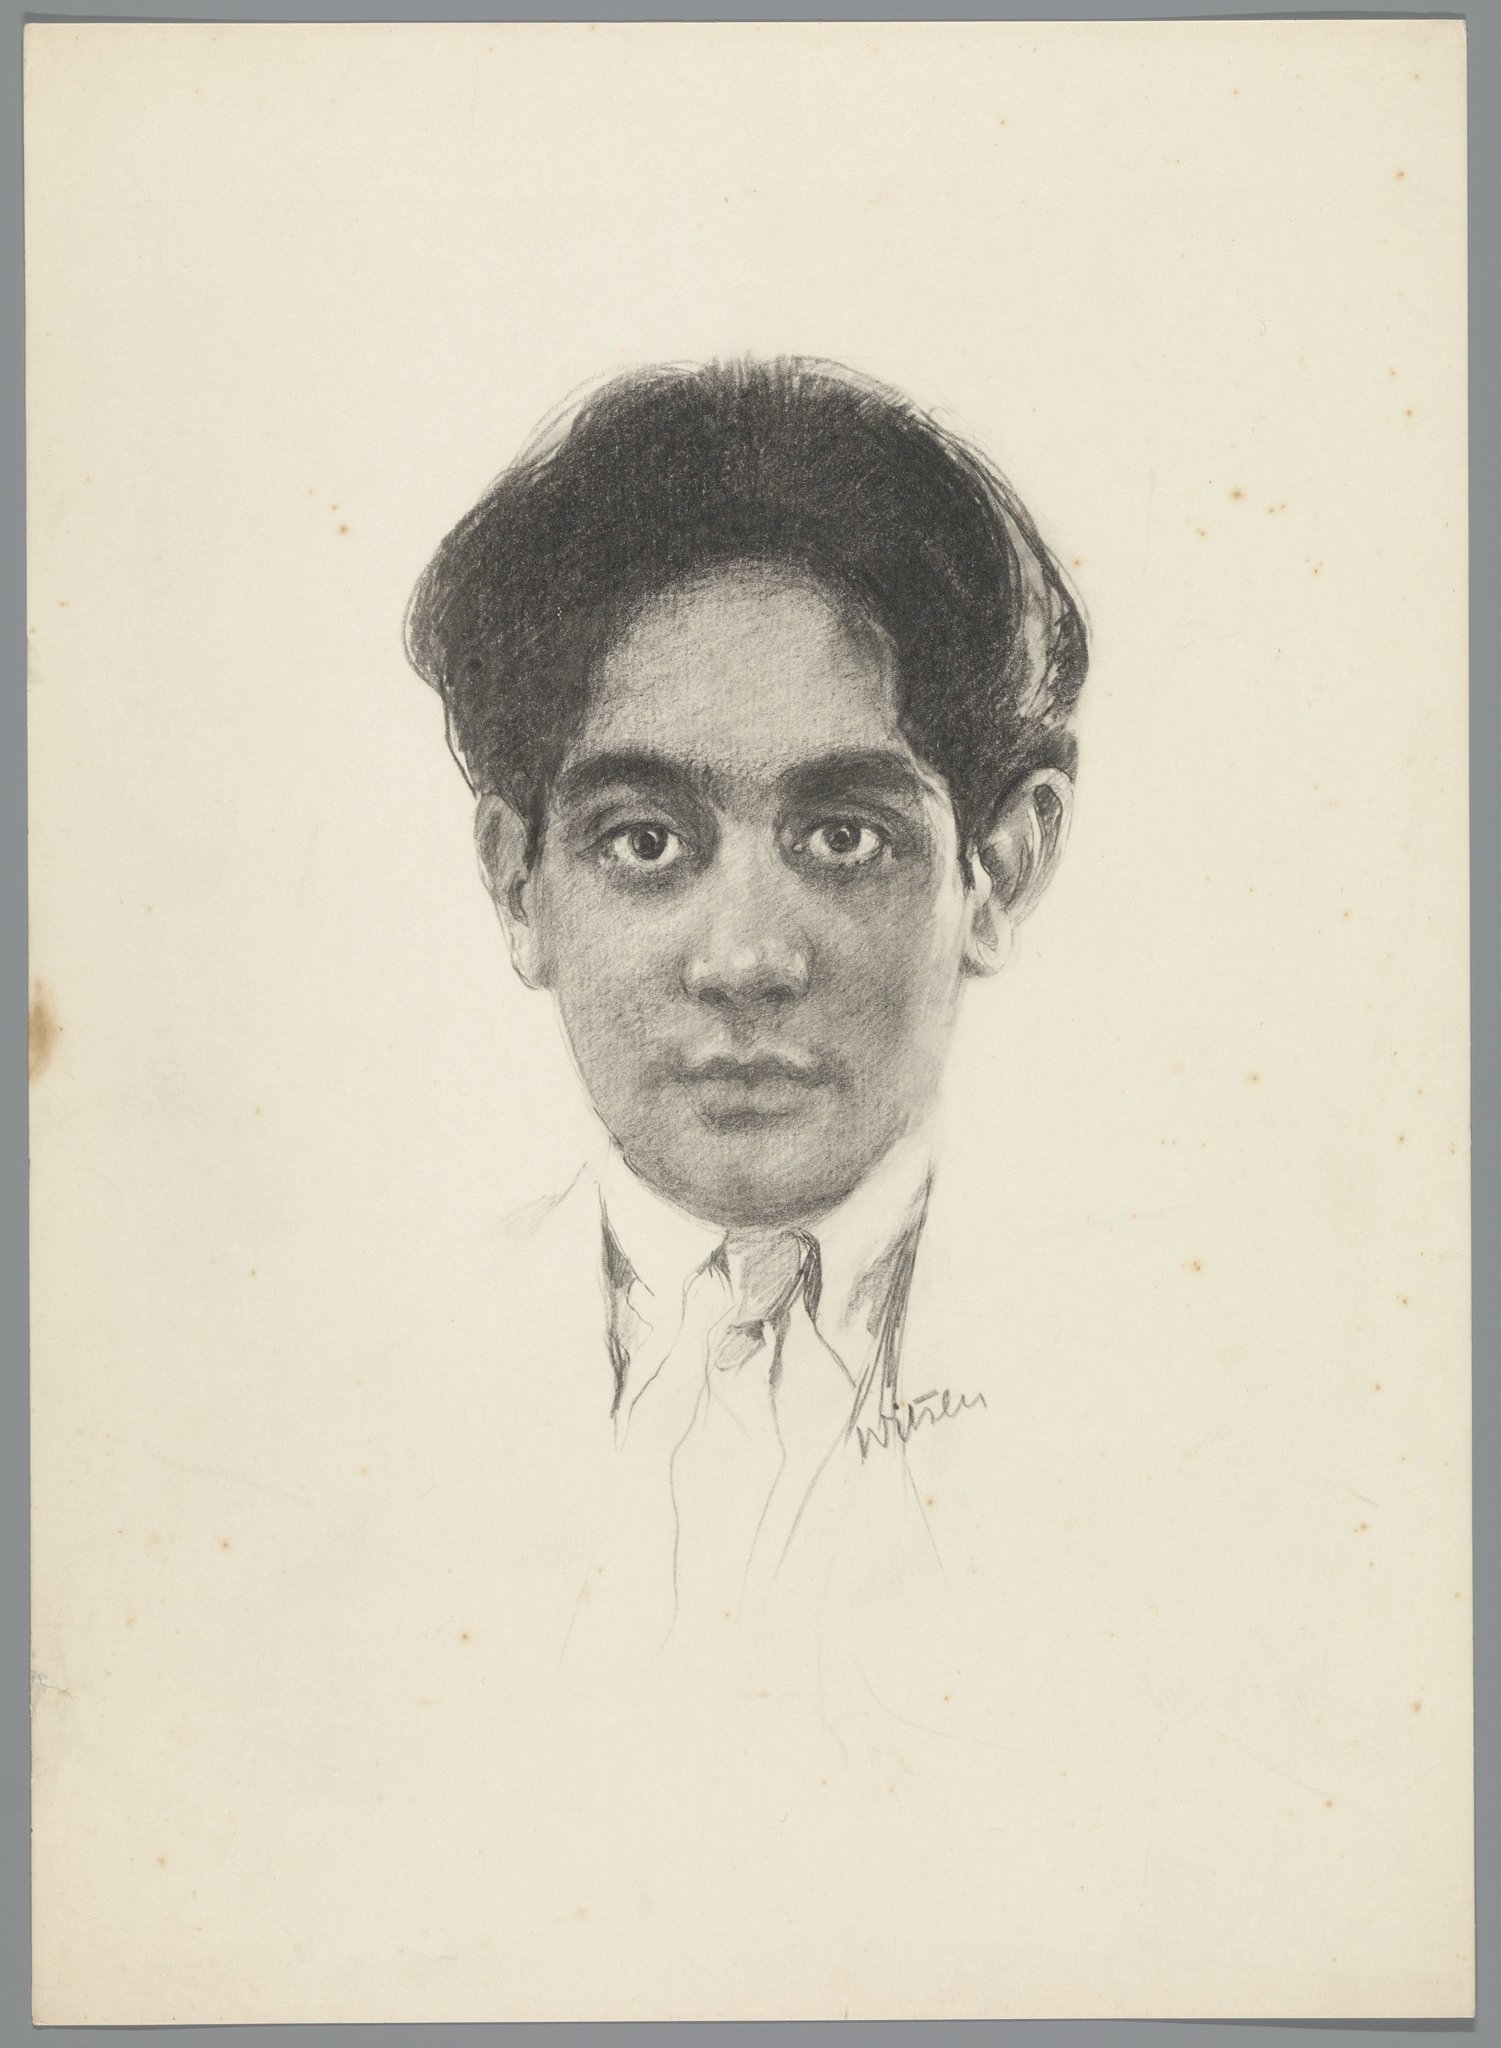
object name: photomechanical print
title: Reproductie van tekening met portret van Karamjit Singh Sahib Bahadur, prins van Kapurthala, door Willem Witsen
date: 1915-1916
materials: paper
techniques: photograph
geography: netherlands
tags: politician, historical persons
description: Voor schilderij van de geportretteerde door Witsen, zie collectie Dordrechts Museum (bruikleen RCE).